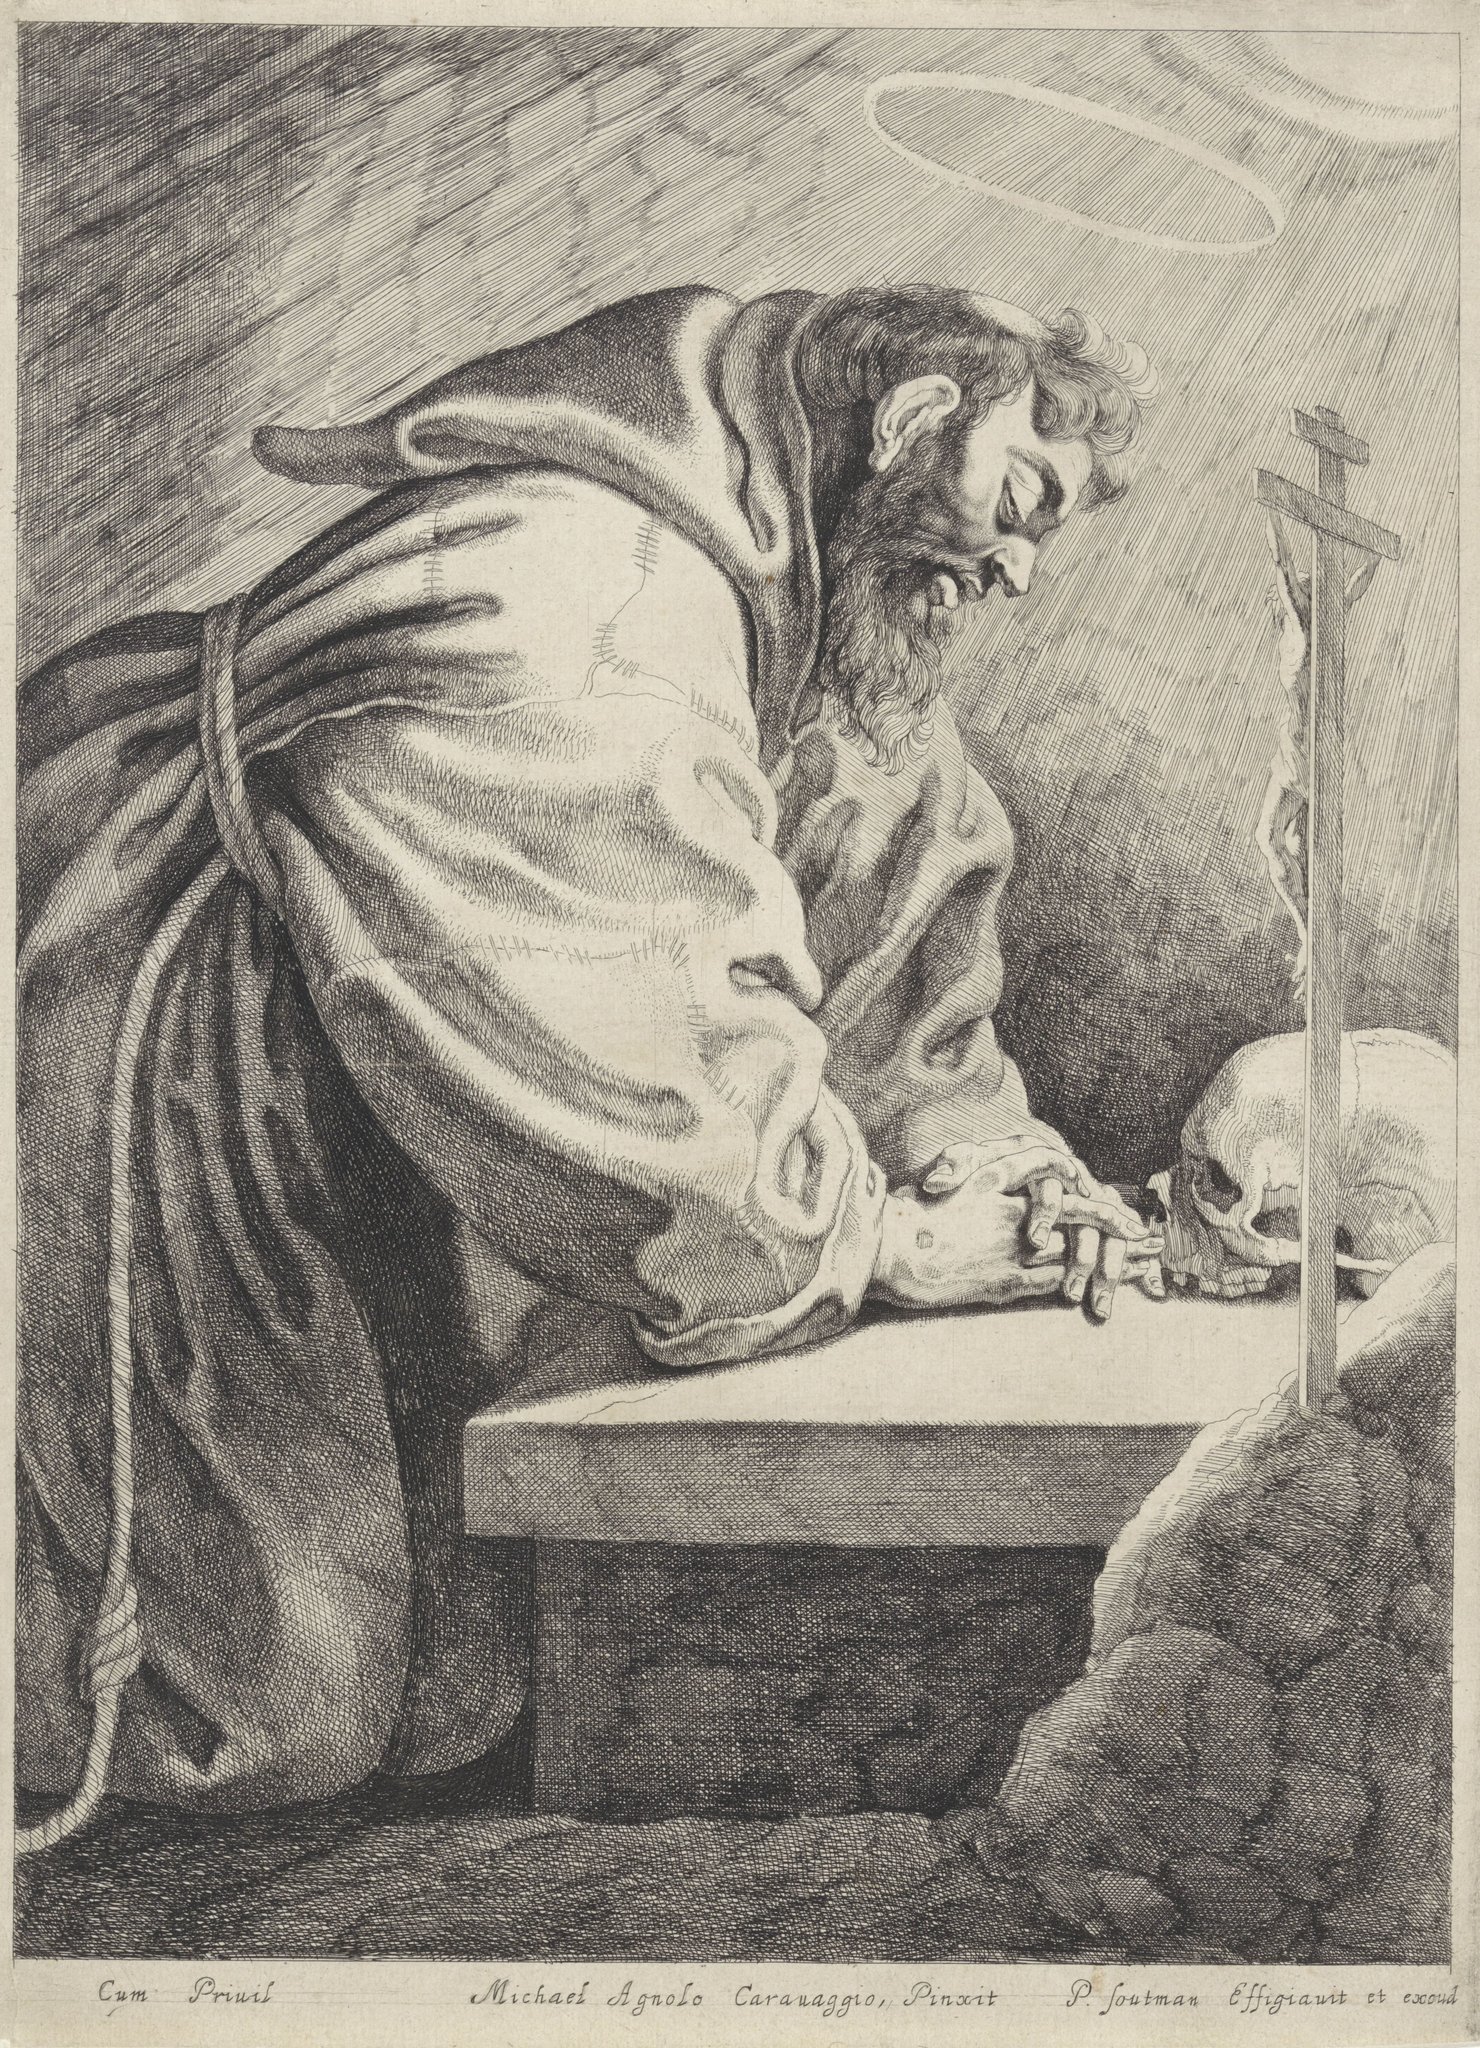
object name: print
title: De heilige Franciscus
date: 1616-1657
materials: paper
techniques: etching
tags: founder of the order of friars minor (franciscans), francis(cus) of assisi; possible attributes: book, crucifix, lily, skull, stigmata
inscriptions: collector's mark: Lugt 240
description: De heilige Franciscus zit biddend op zijn knieën voor een laag altaar met crucifix. Op het altaar ligt een schedel.